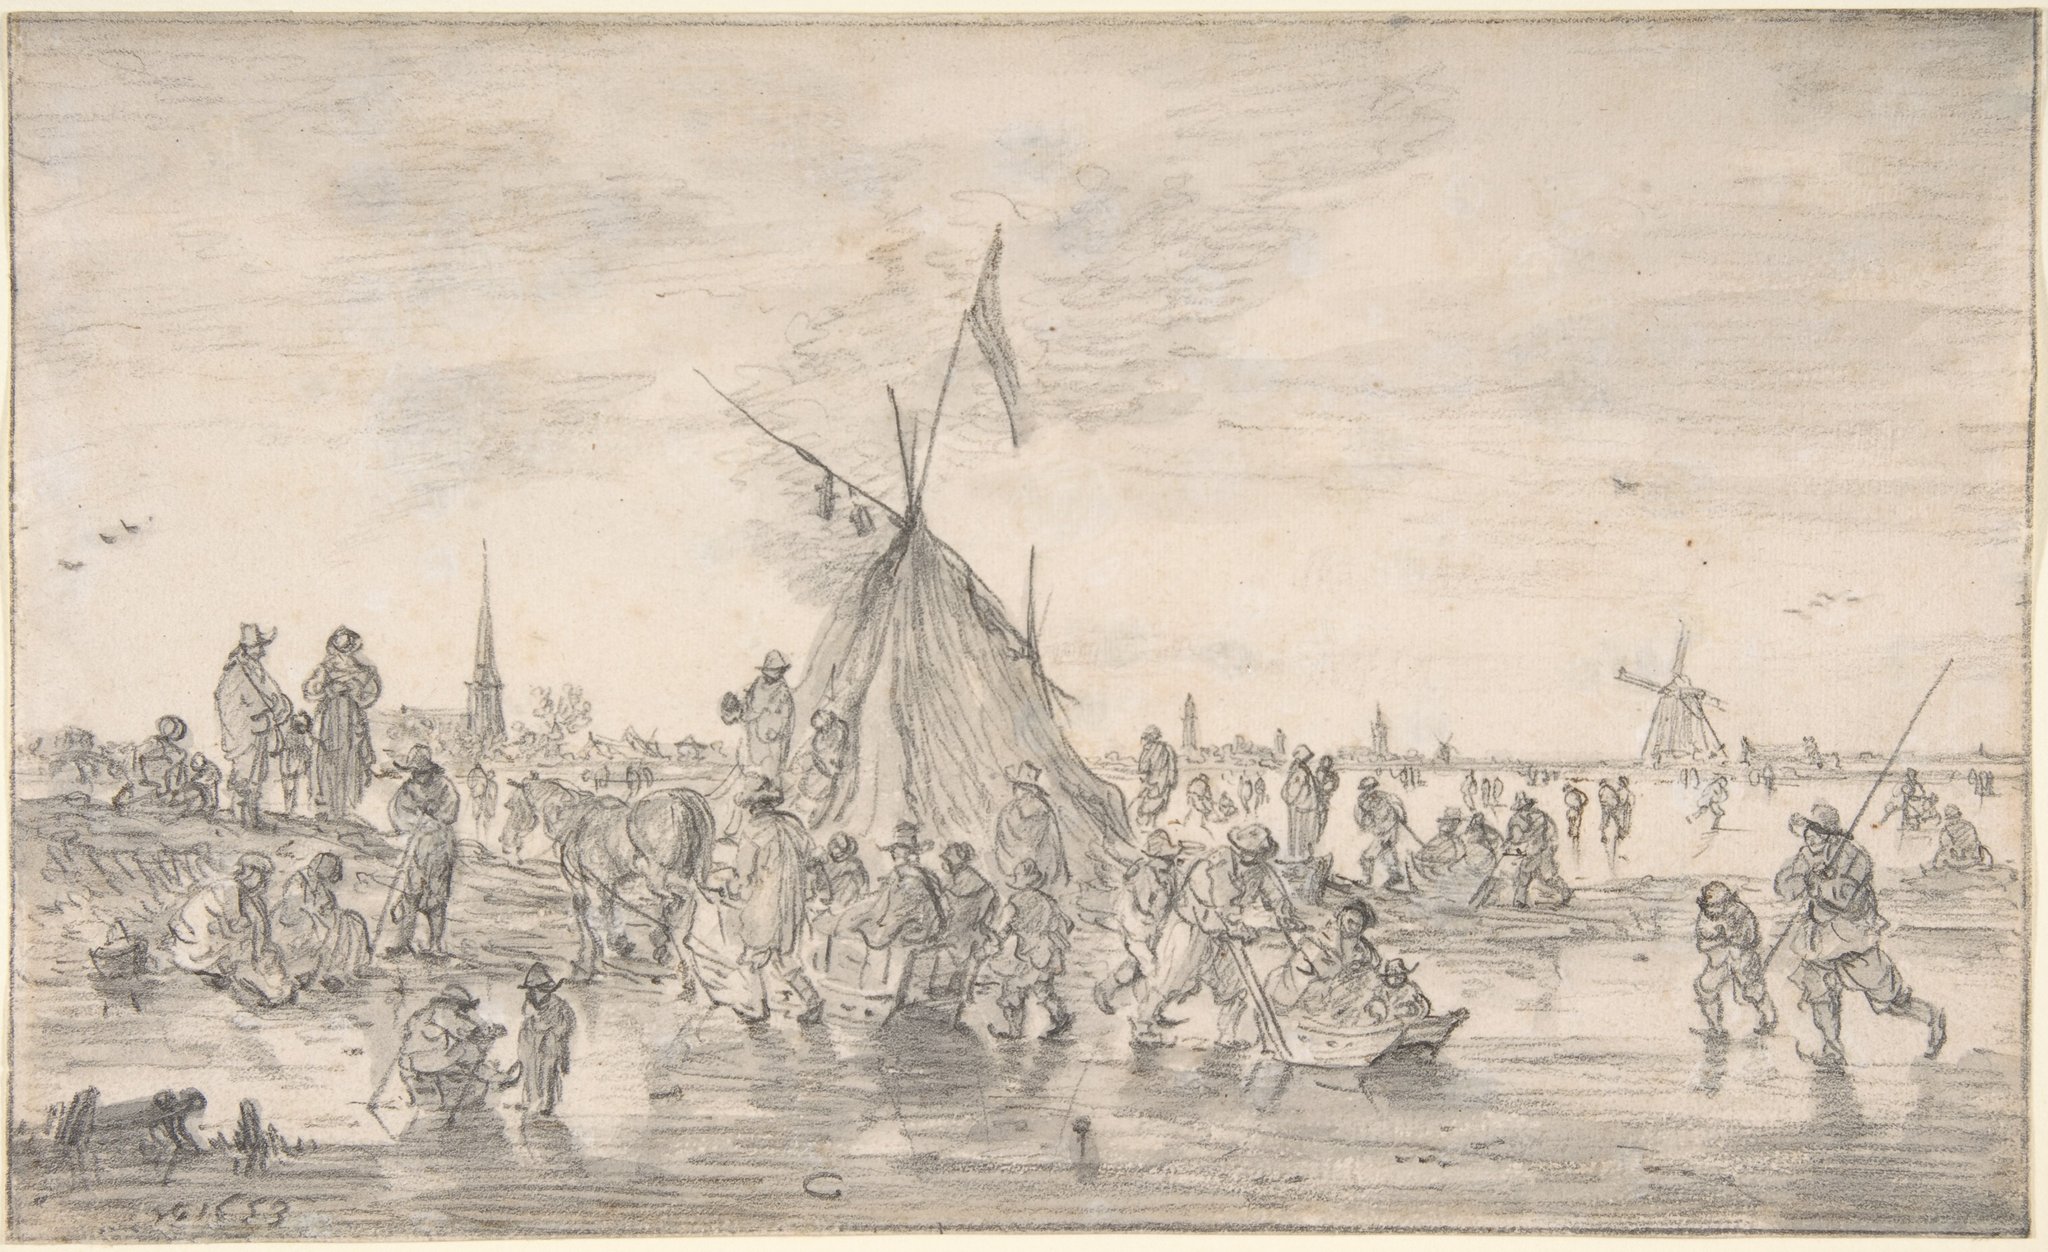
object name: drawing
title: Winter Landscape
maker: jan van goyen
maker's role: artist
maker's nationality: dutch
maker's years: 1596-1656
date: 1653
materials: chalk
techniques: wash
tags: human figures,landscapes